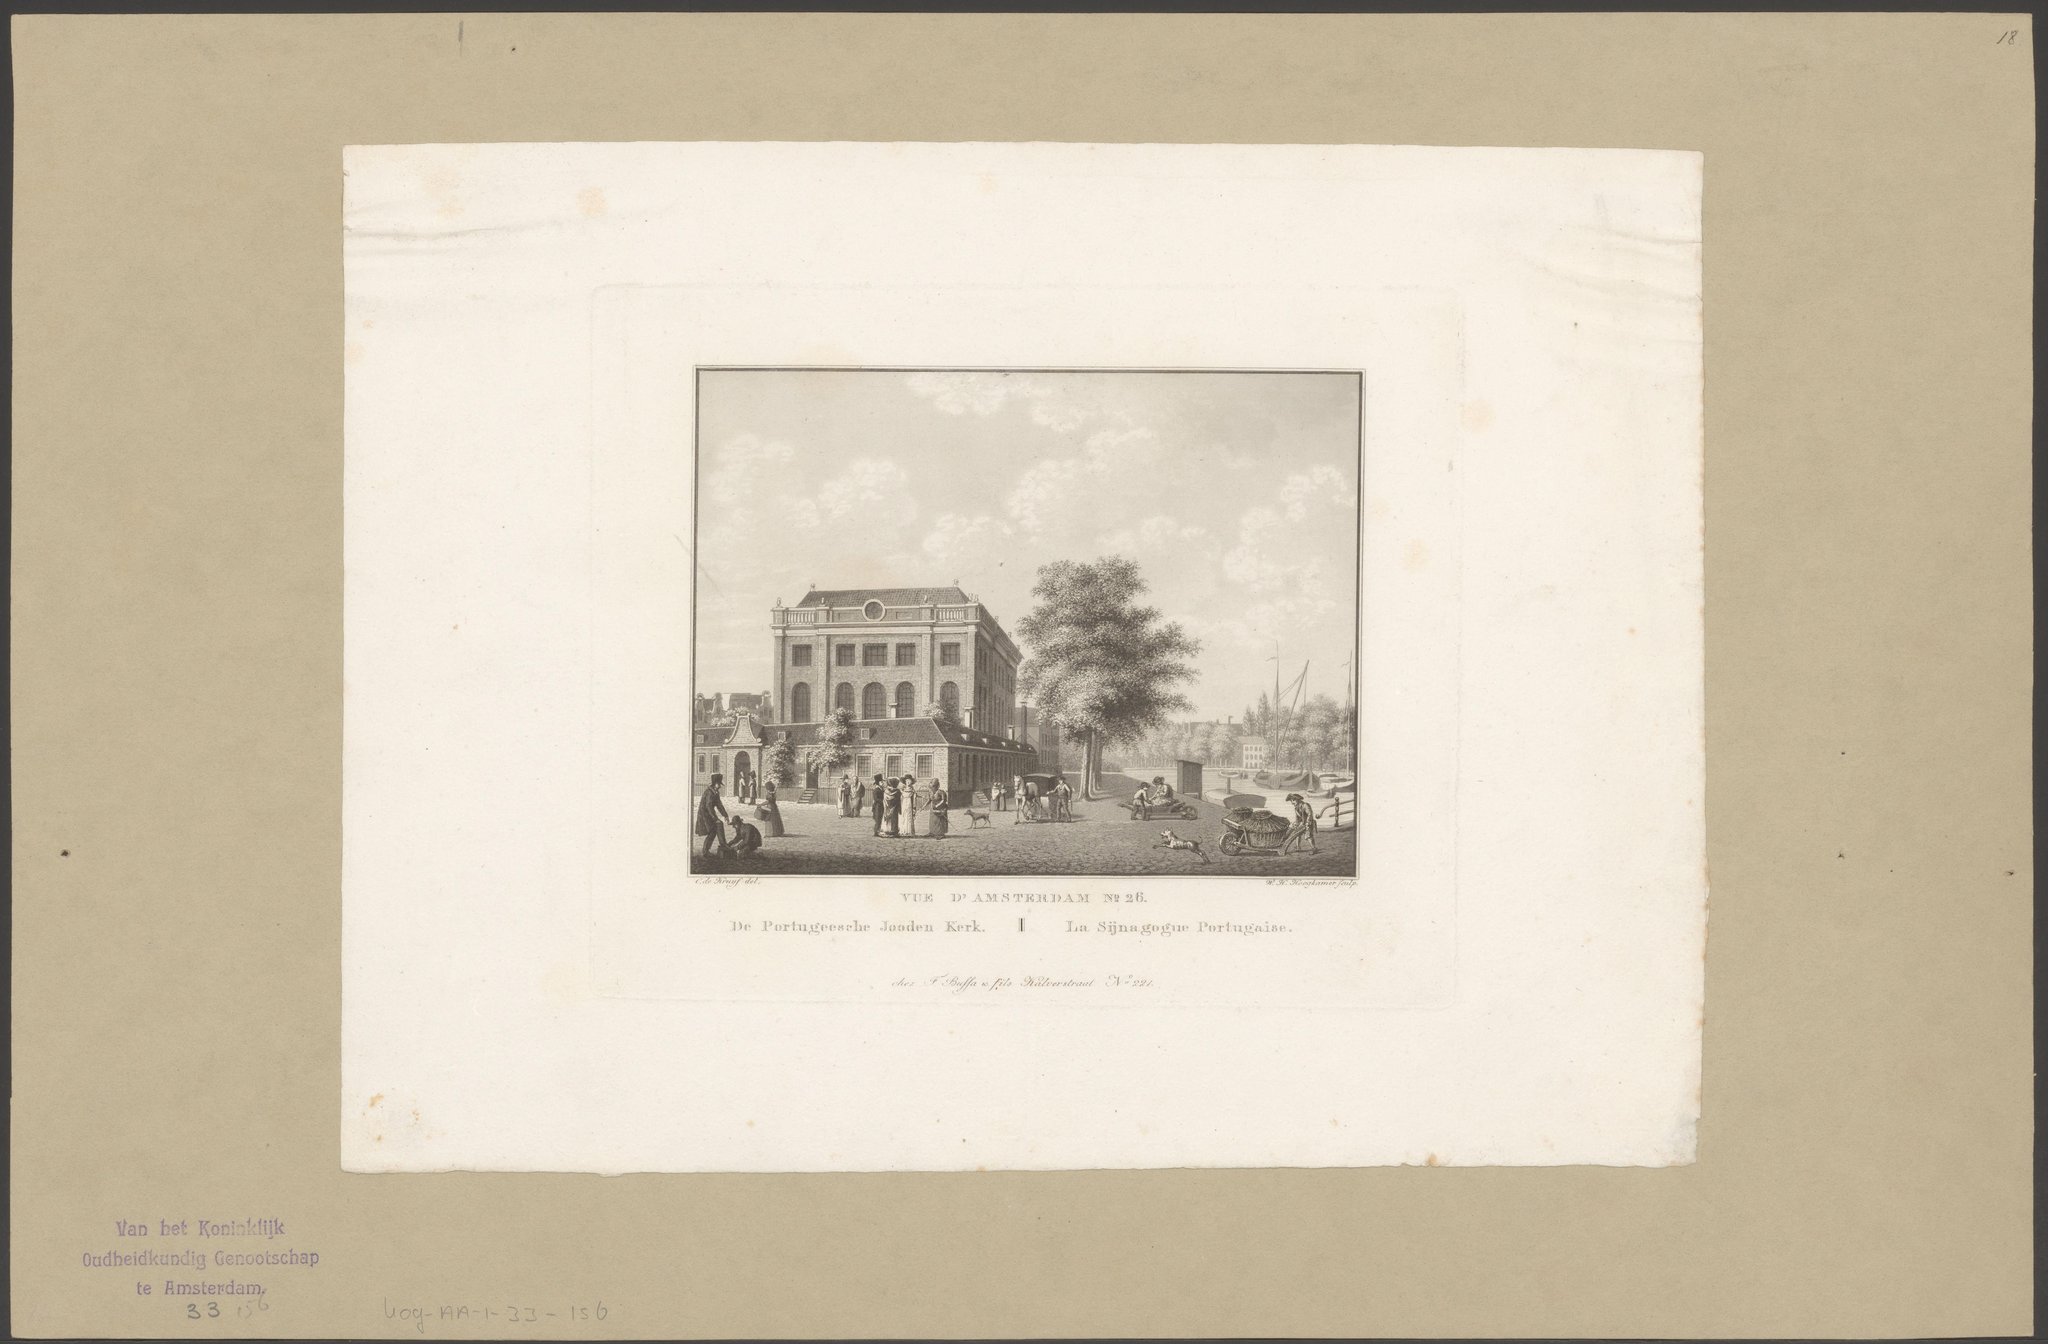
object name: print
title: Gezicht op de Portugese Synagoge te Amsterdam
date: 1825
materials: paper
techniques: aquatint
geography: amsterdam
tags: the synagogue (as building and place of worship ~ jewish religion), canals, waters (in city), street (+ city(-scape) with figures, staffage)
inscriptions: collector's mark: ‘ Van het Koninklijk Oudheidkundig Genootschap te Amsterdam. ’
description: Onderwerpsrubriek binnen de Atlas Amsterdam: Kerkwezen: Gebouwen diverse gemeenten: Portugees-Israëlitische Gemeente + rabbijnen.